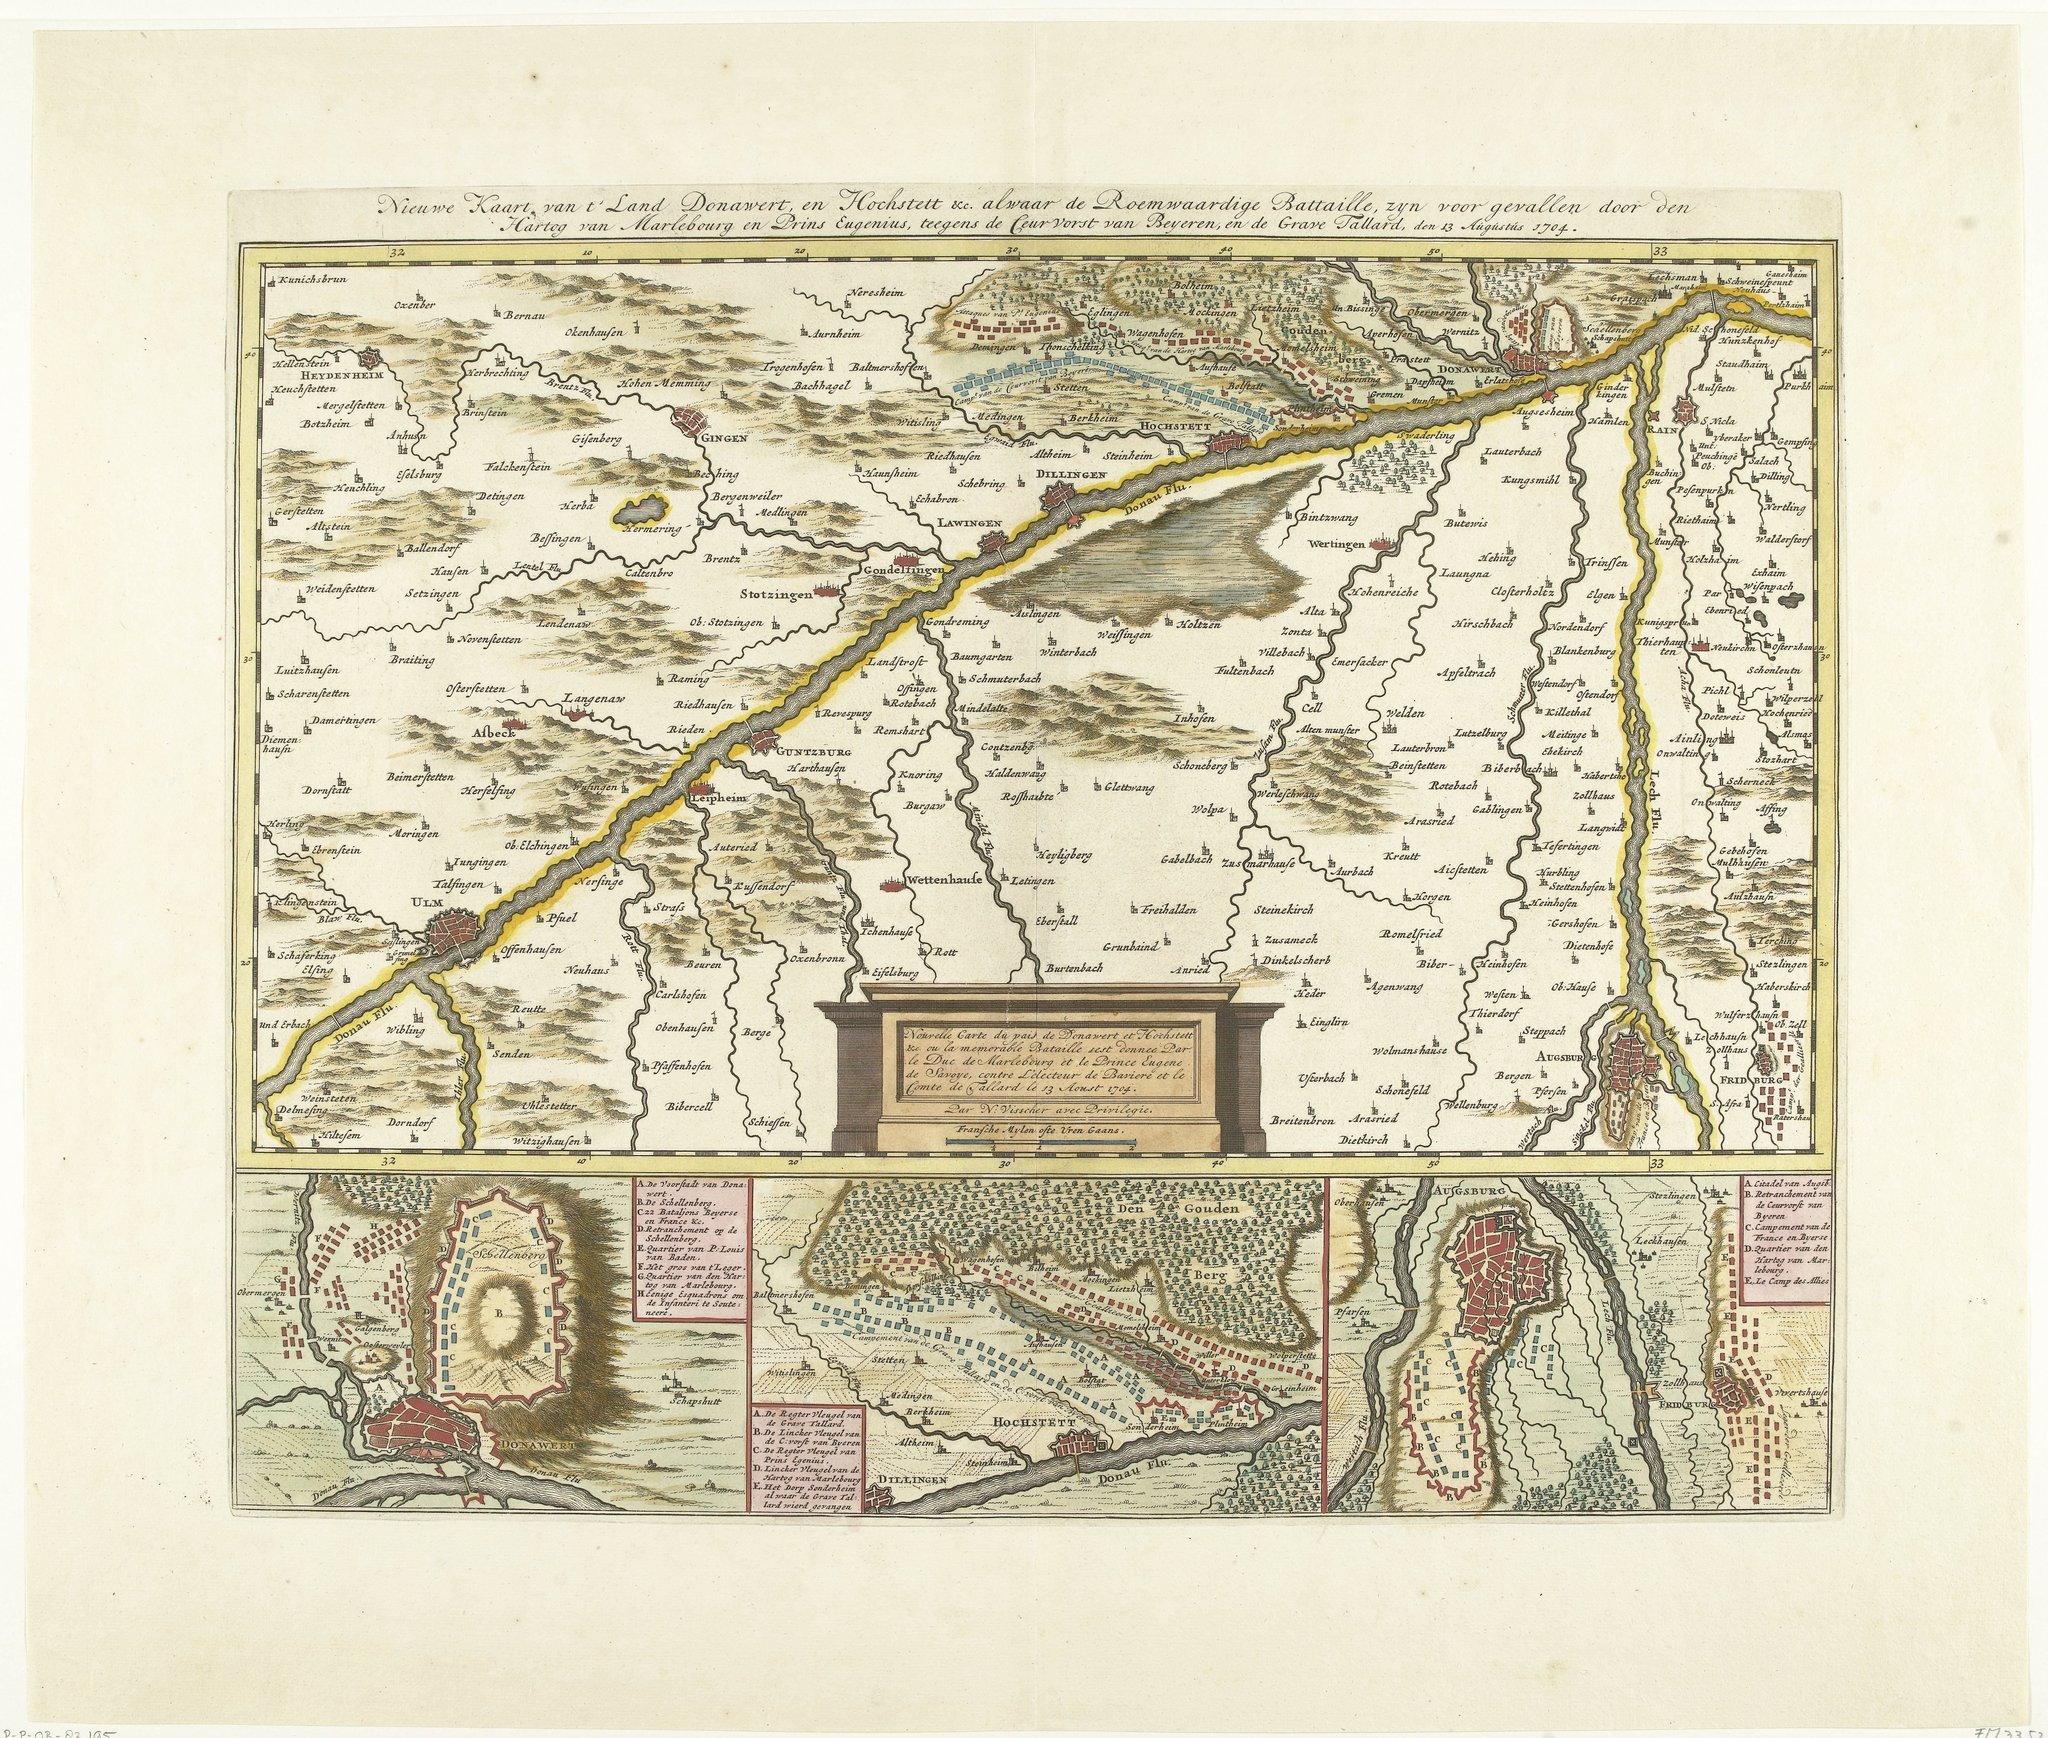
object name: print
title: Nieuwe Kaart van t'Land Donawert, en Hochstett &c. alwaar de Roemwaardige Battaille, zyn voor gevallen door den Hartog van Marlebourg en Prins Eugenius, teegens de Ceurvorst van Beyeren, en de Grave Tallard, den 13 Augustus 1704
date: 1704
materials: paper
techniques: etching, hand coloring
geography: northern netherlands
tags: maximiliaan ii emanuel (keurvorst van beieren), paris, vienna, eugenius van savoye, john churchill (1e hertog van marlborough), maps of separate countries or regions, maps of cities, augsburg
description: Kaart van Donawert, de streek rondom de Donau tussen Donauwörth en Ulm, locatie van de slag bij Höchstädt (slag bij Blenheim) met een overwinning van de Geallieerden op de Fransen en de Beiersen, 13 augustus 1704. Onderaan drie deatils van Schellenberg, Hochstett en Augsburg.